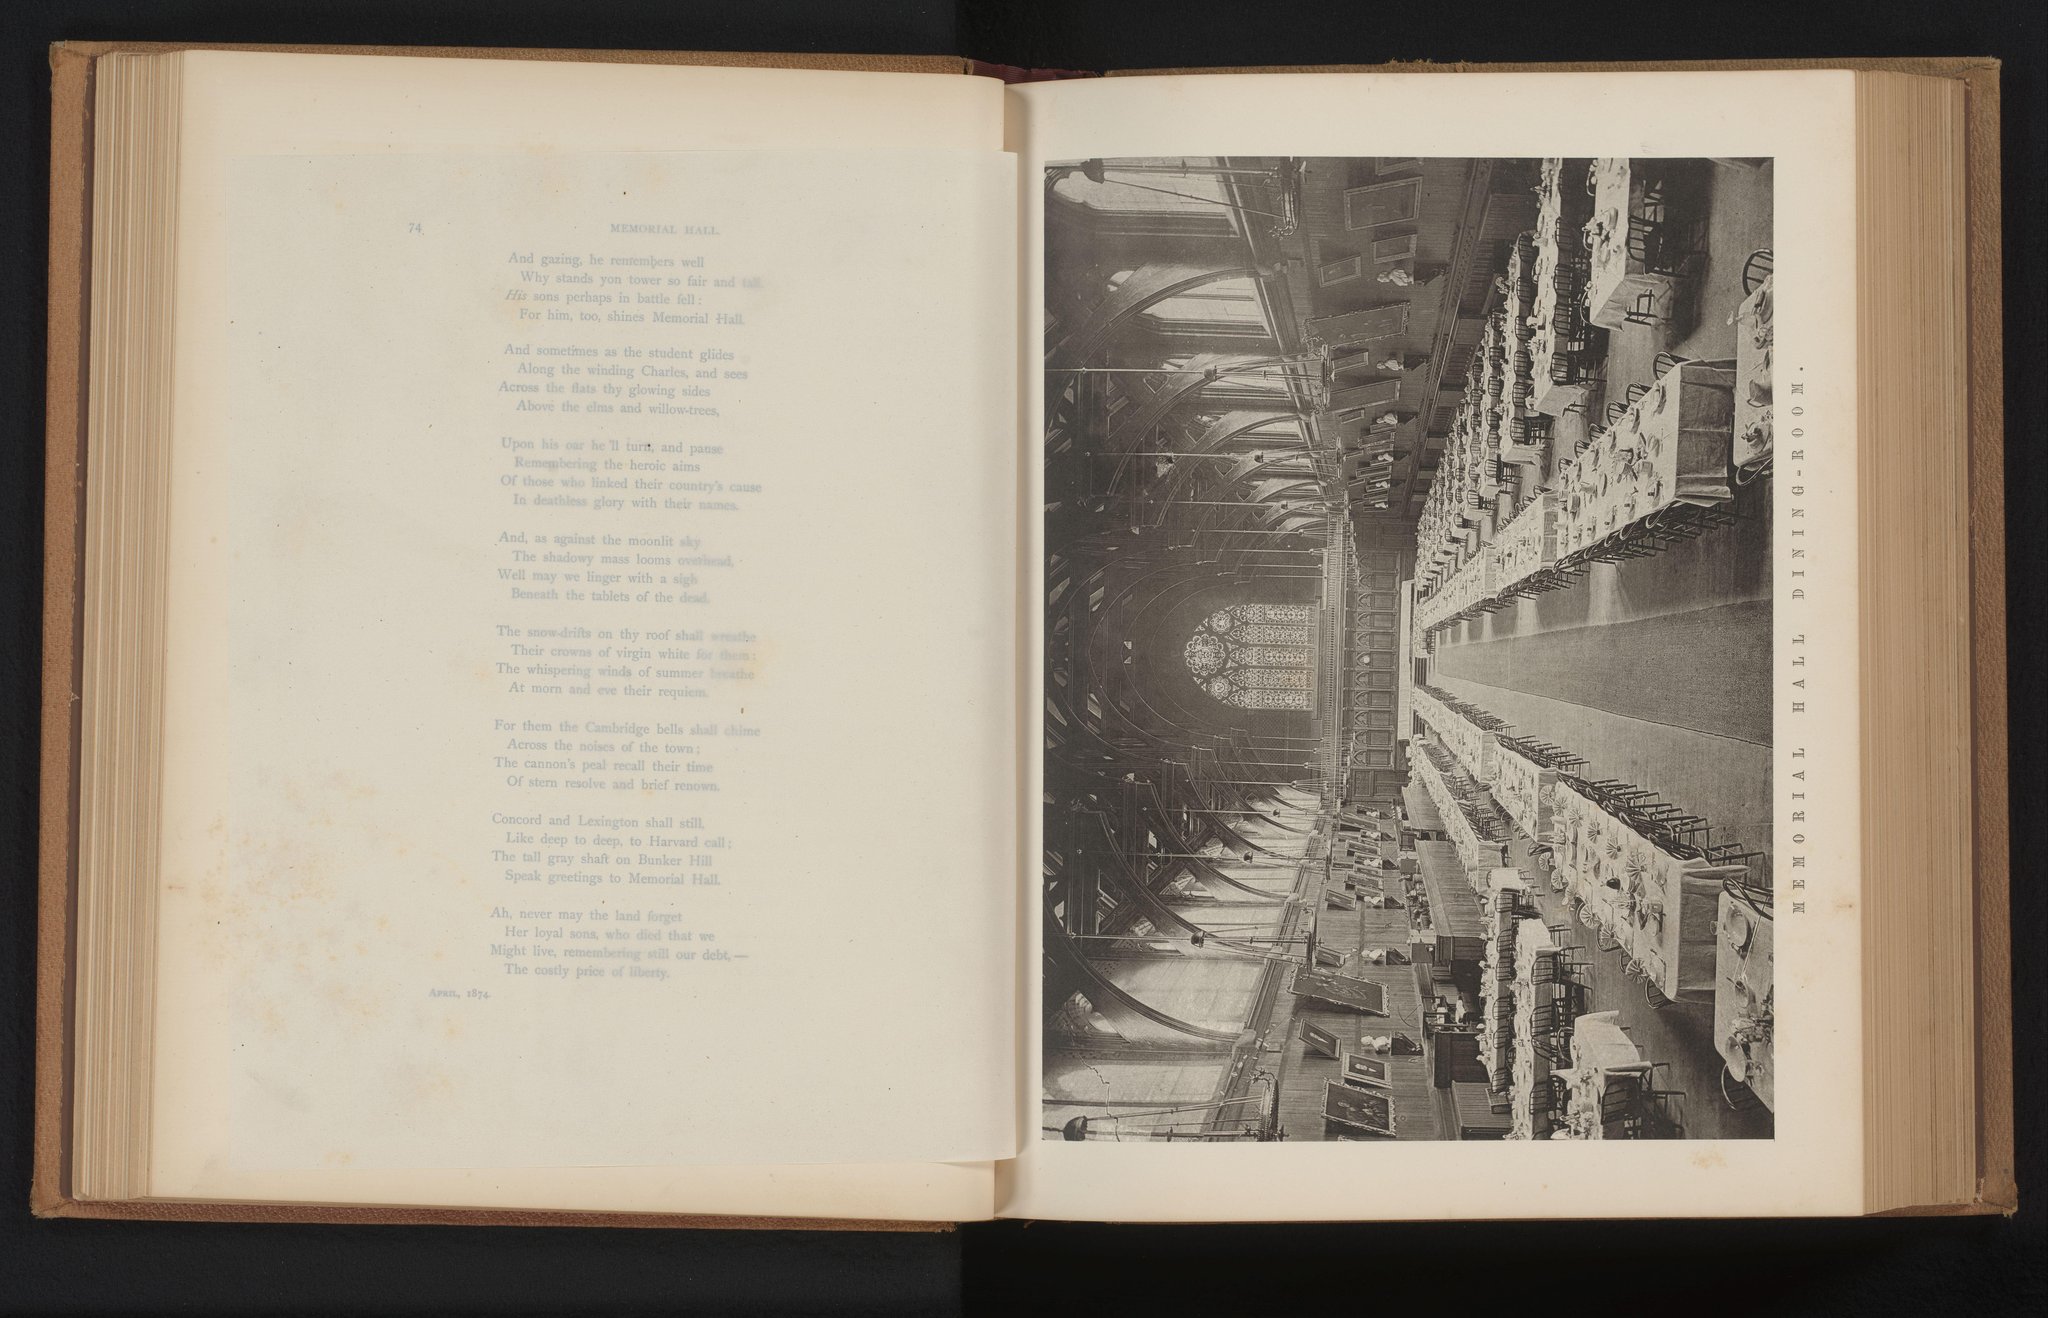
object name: page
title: Memorial Hall dining-room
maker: Anonymous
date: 1870-1875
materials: paper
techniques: photograph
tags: university building, college, dining-room